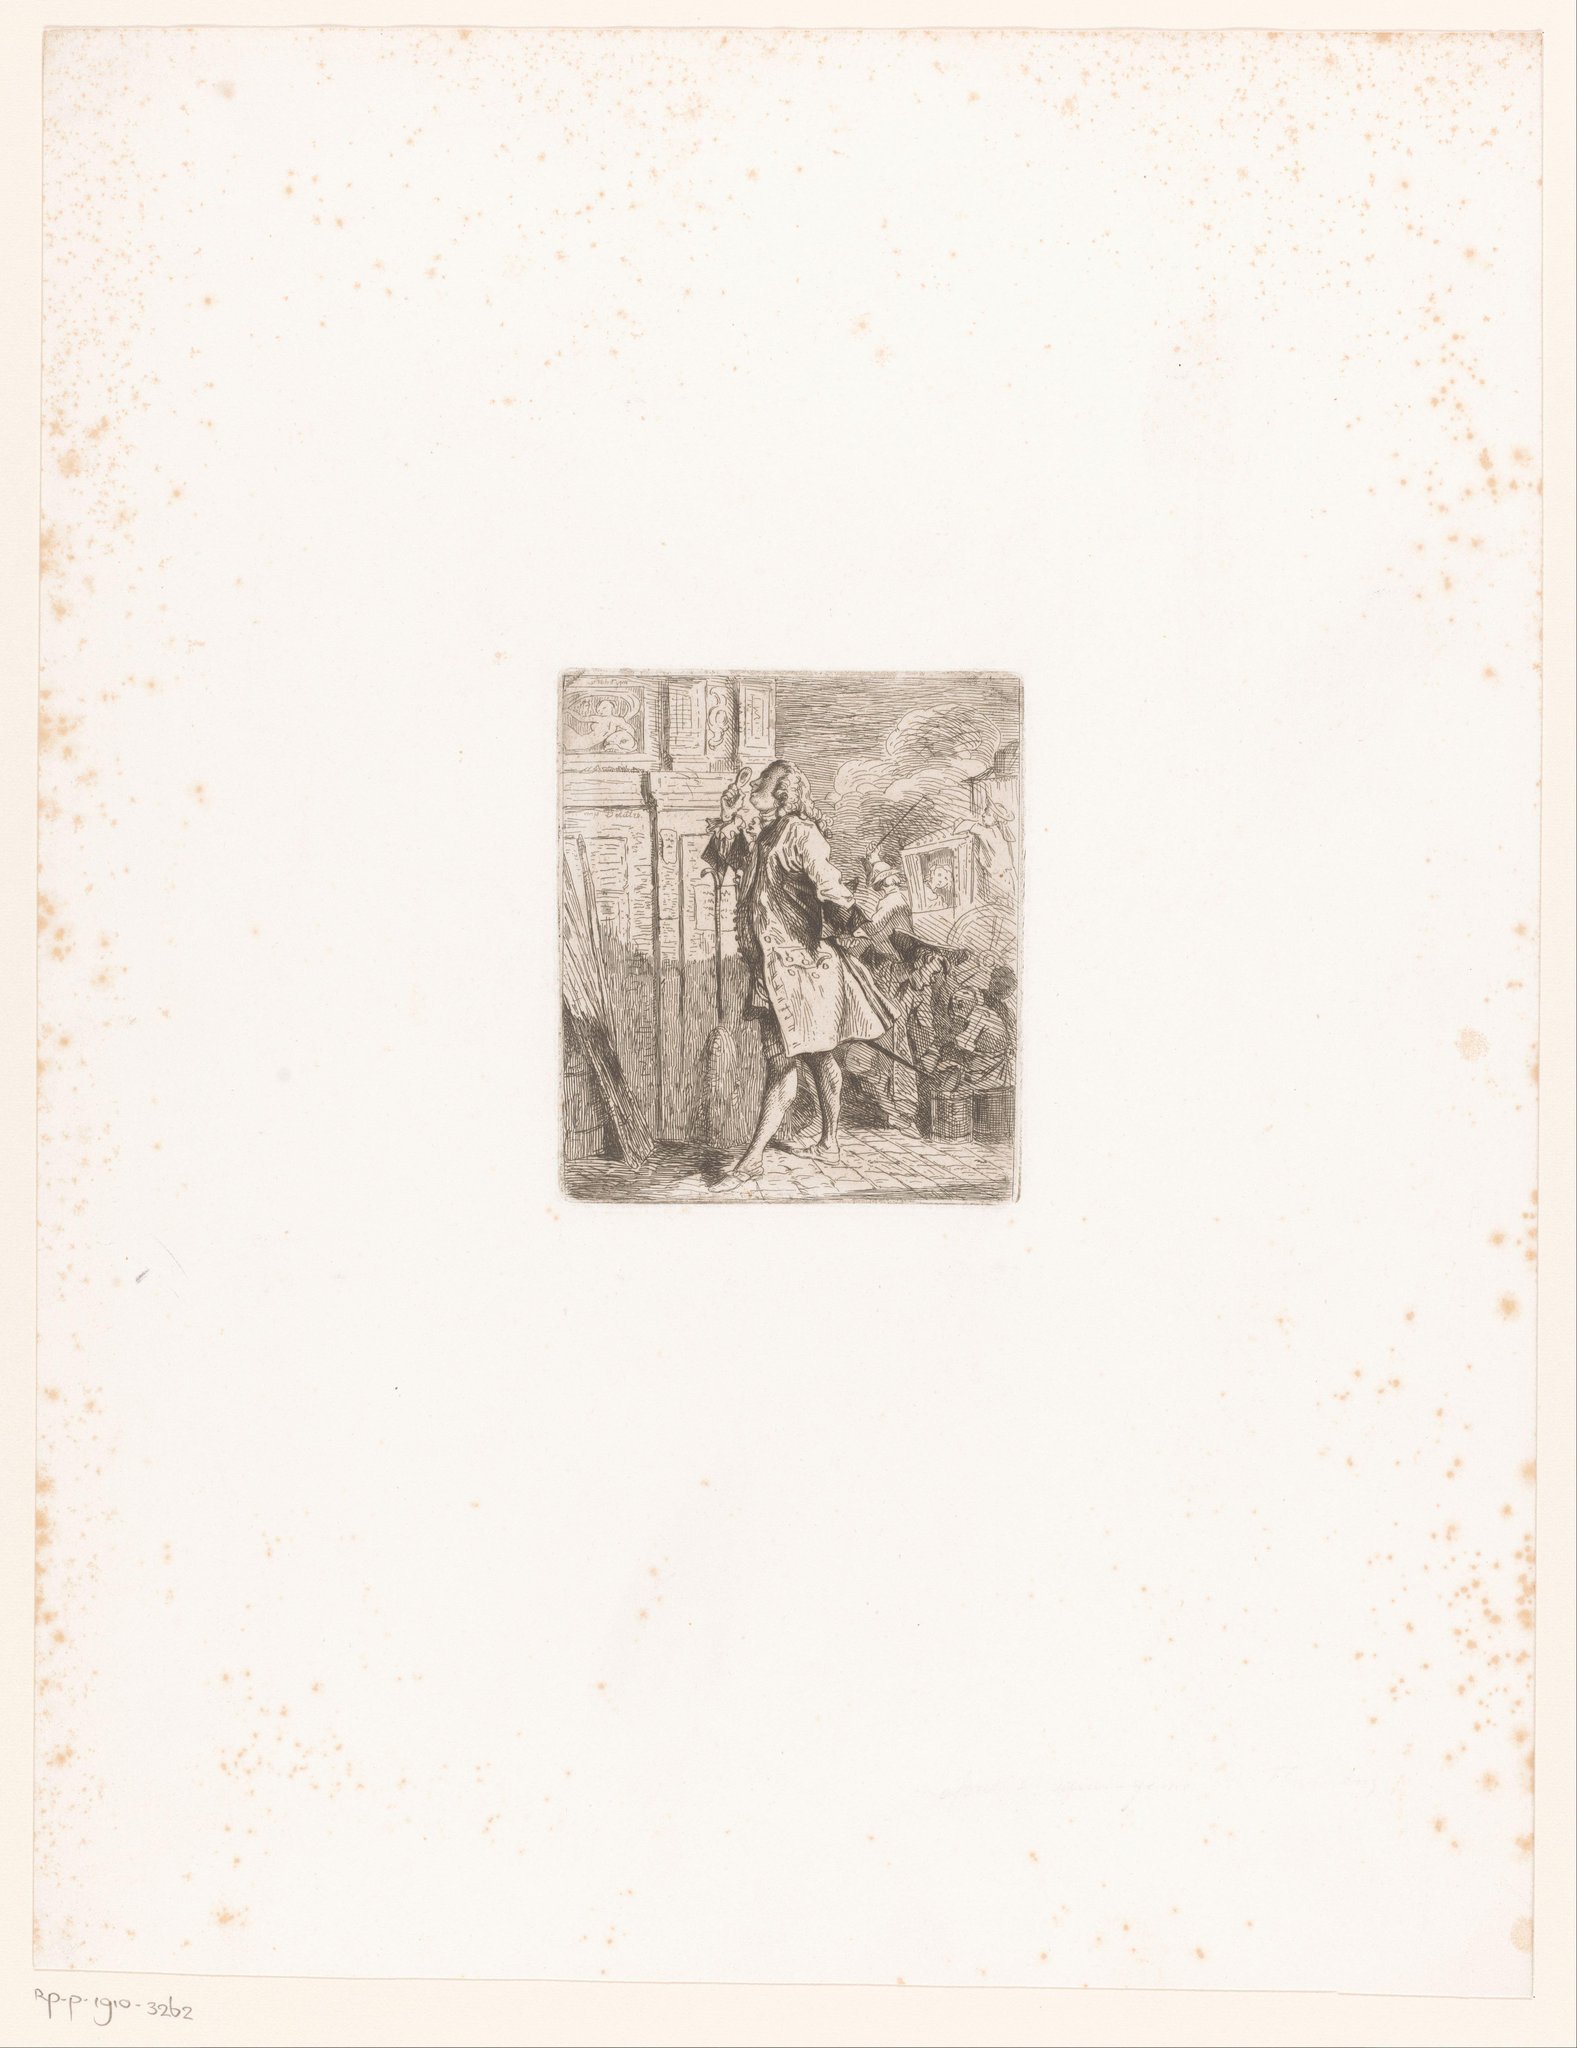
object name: print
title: Man bestudeert architectonische details, een koets op de achtergrond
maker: léopold flameng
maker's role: print maker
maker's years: 1831-1911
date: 1841-1910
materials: paper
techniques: etching, intaglio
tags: artist (in general) studying classical remains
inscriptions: collector's mark: Lugt 2228